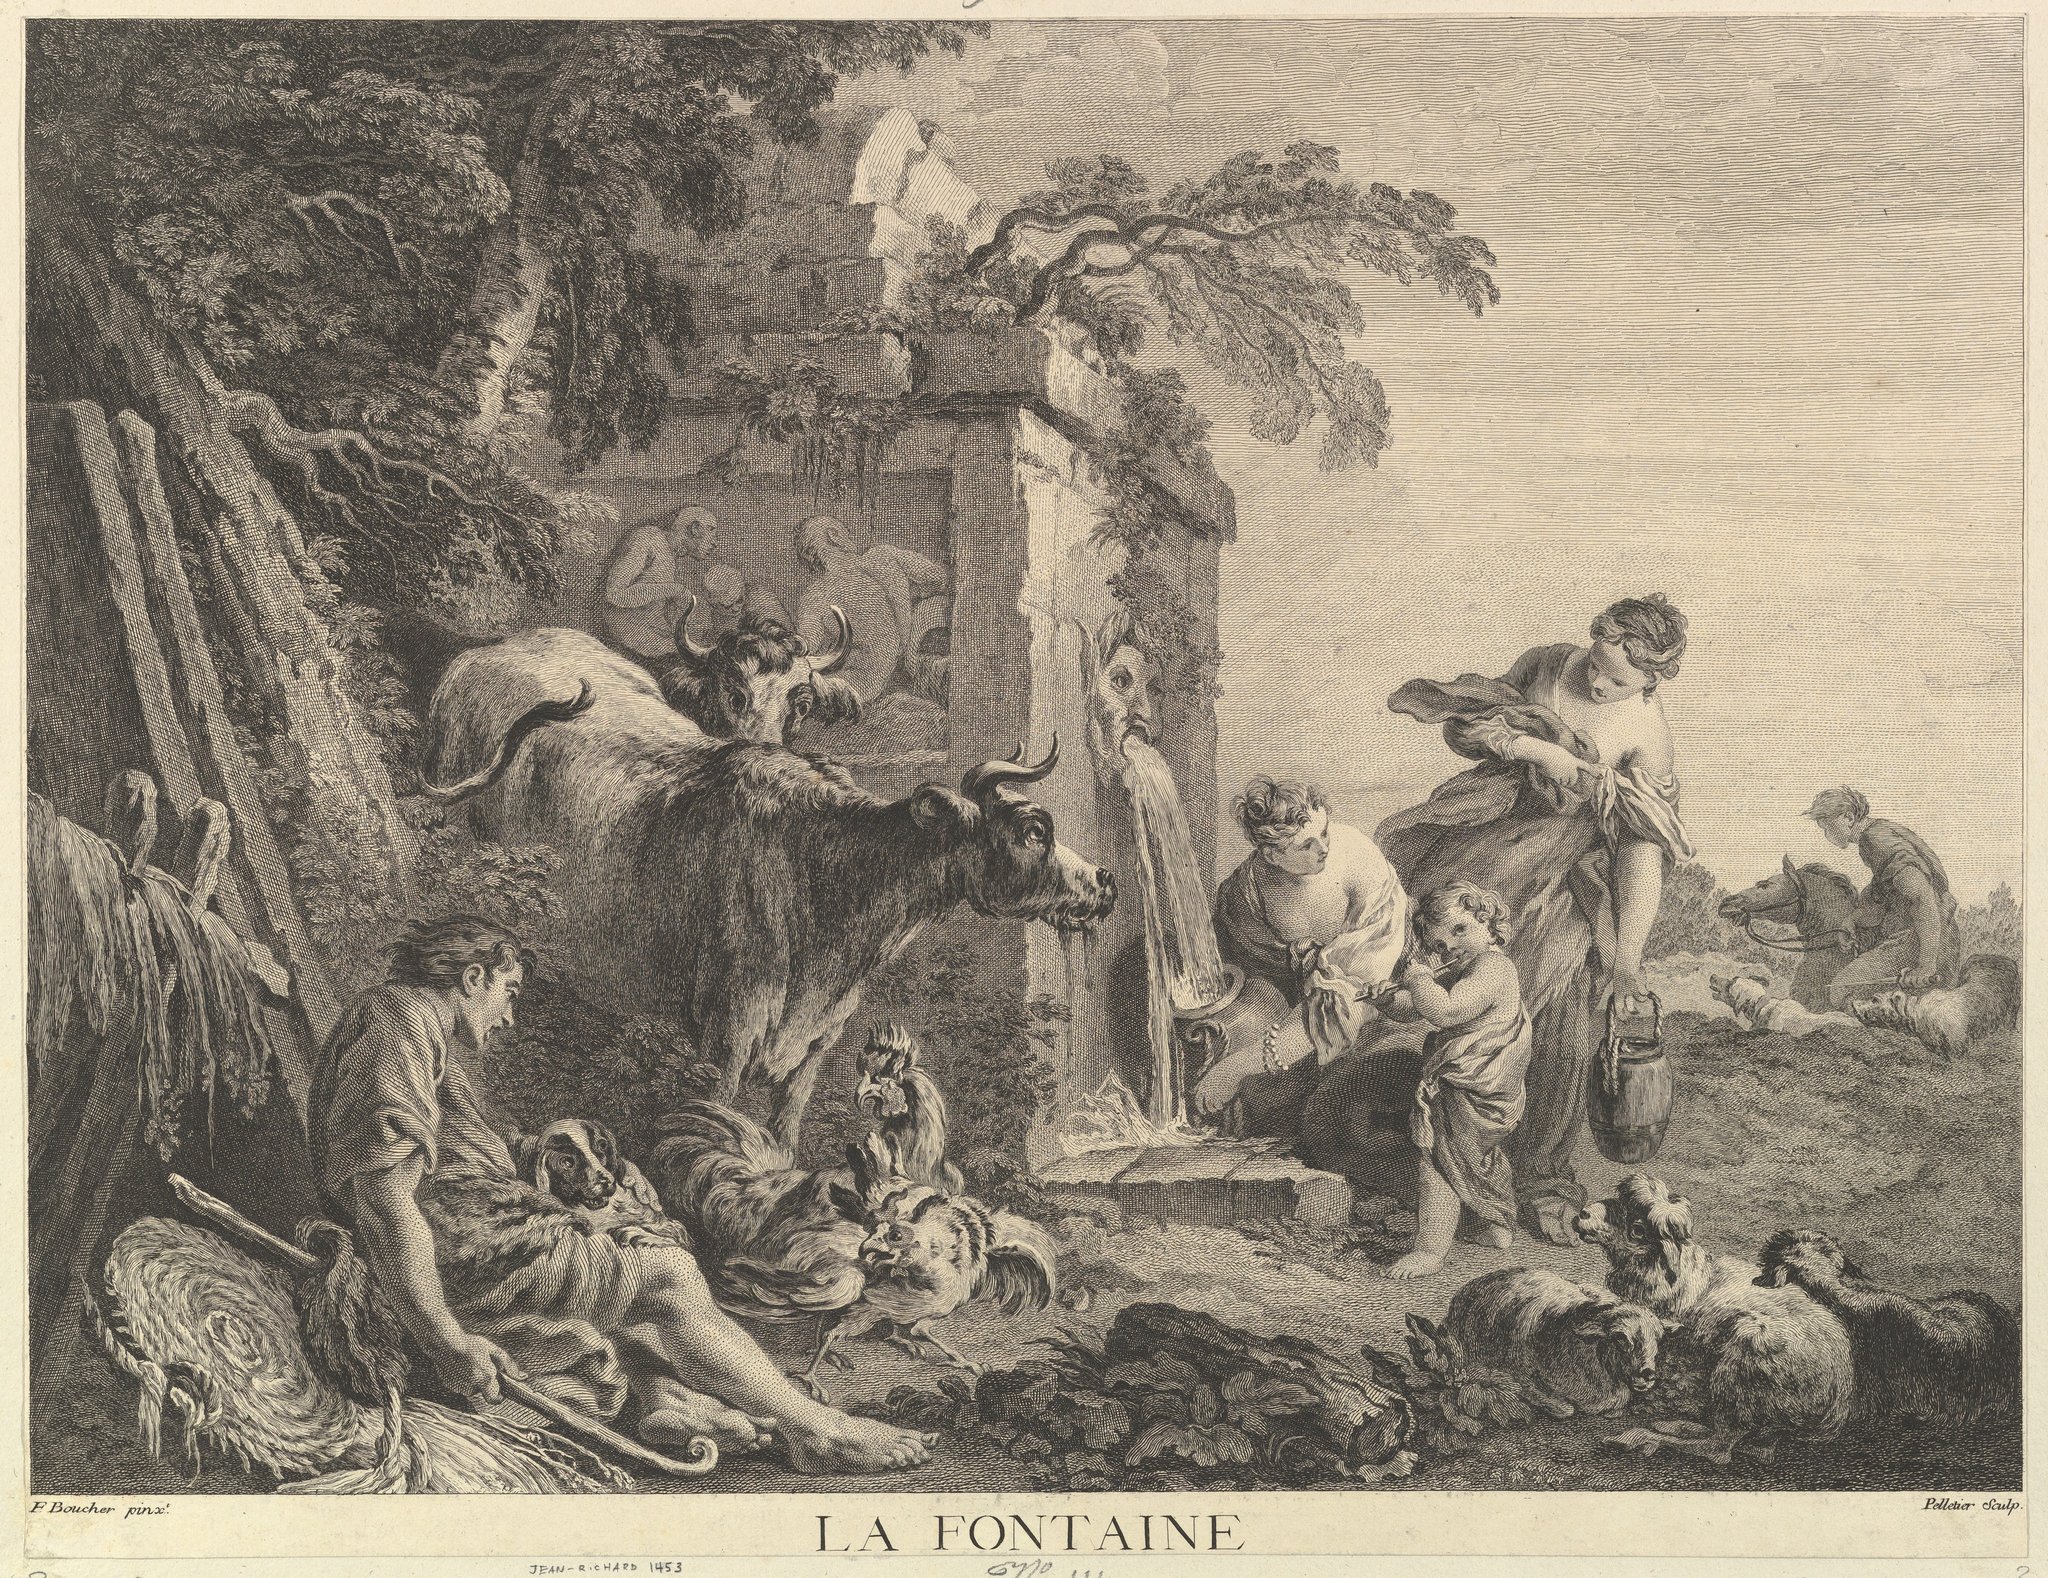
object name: print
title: The Fountain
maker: jean pelletier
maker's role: artist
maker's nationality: french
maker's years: 1736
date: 1736-1800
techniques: engraving, etching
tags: animals,fountains,men,women,horses